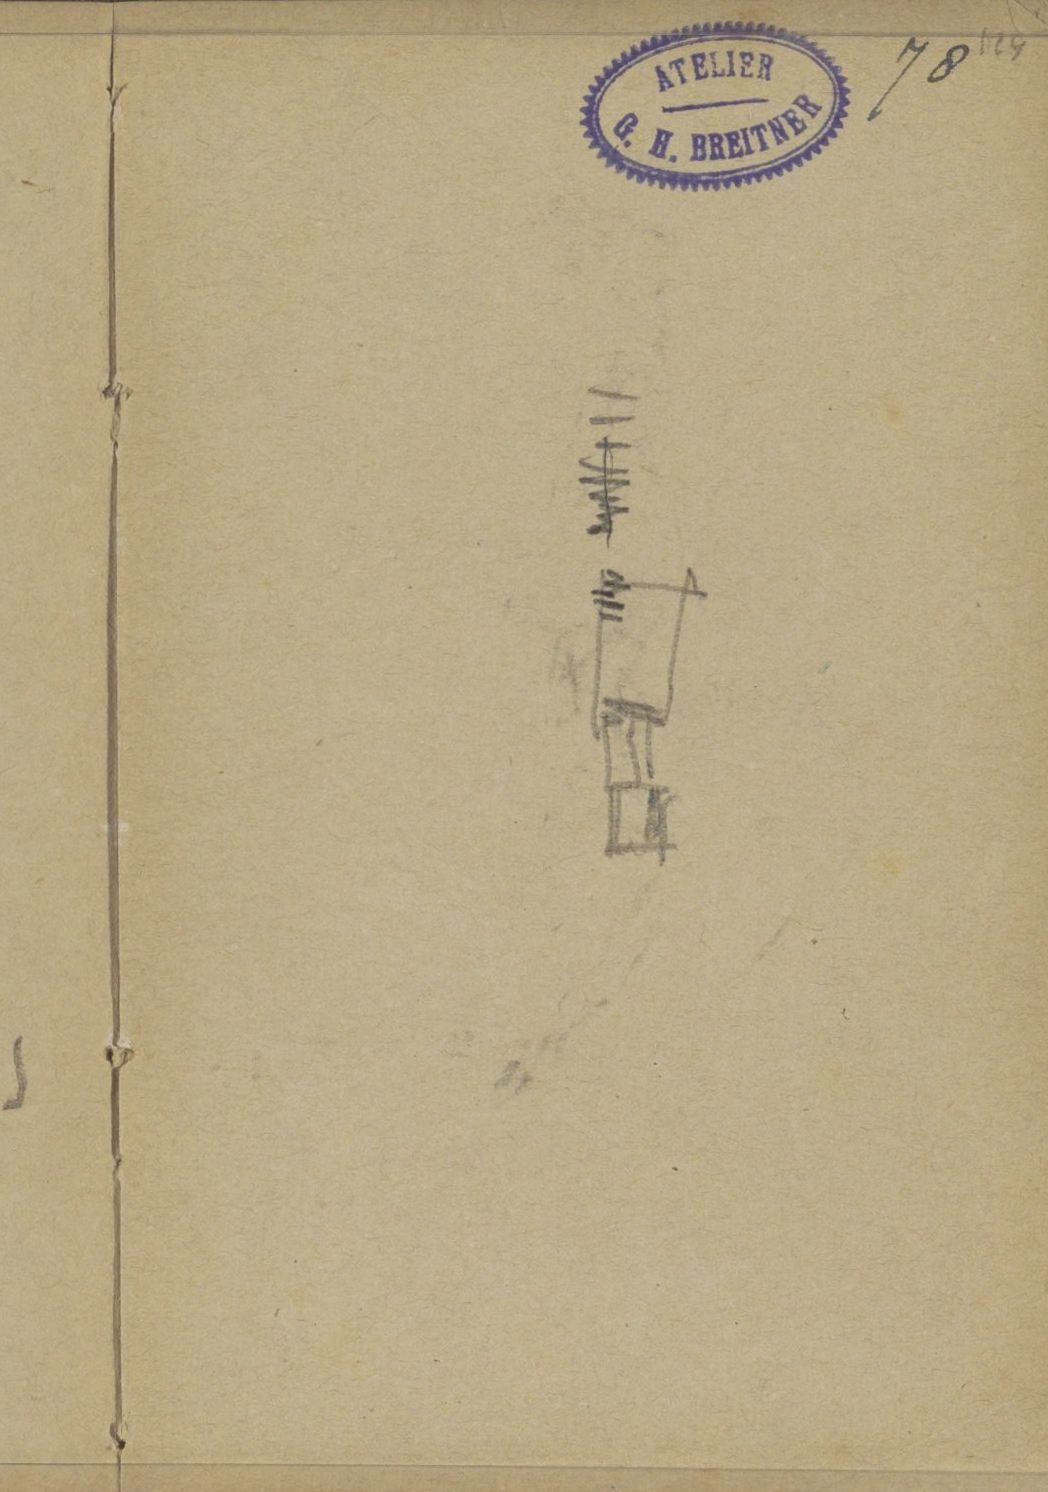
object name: sketchbook leaf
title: Studie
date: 1887-1891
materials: paper, pencil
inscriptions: workshop stamp: Lugt 291d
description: Pagina 124 uit een schetsboek met 83 bladen.